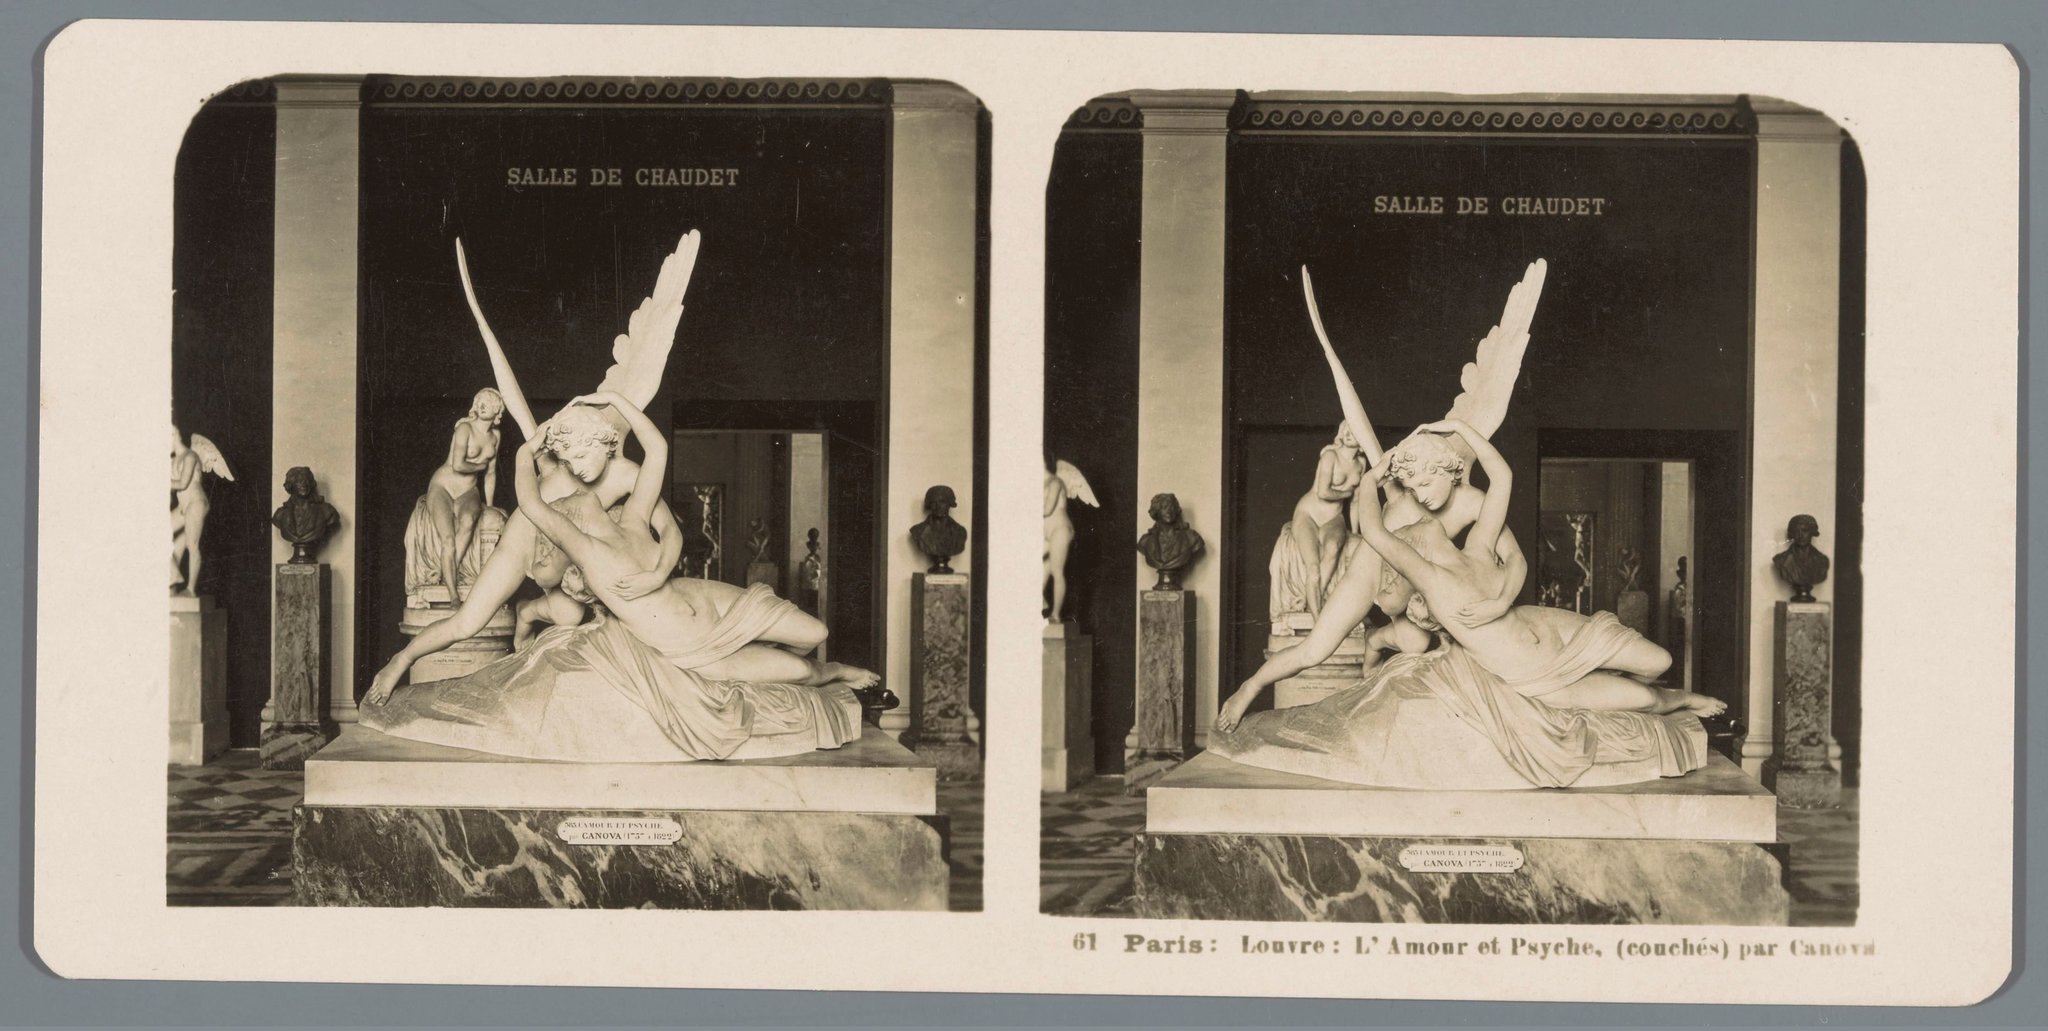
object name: stereograph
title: Sculptuur van Antonio Canova in het Musée du Louvre te Parijs, voorstellende Amor en Psyche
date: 1894-1910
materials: cardboard, photographic support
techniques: gelatin silver print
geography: louvre museum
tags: sitting figure - aa - female human figure, sculpture, cupid and psyche as lovers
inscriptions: number: ‘61’